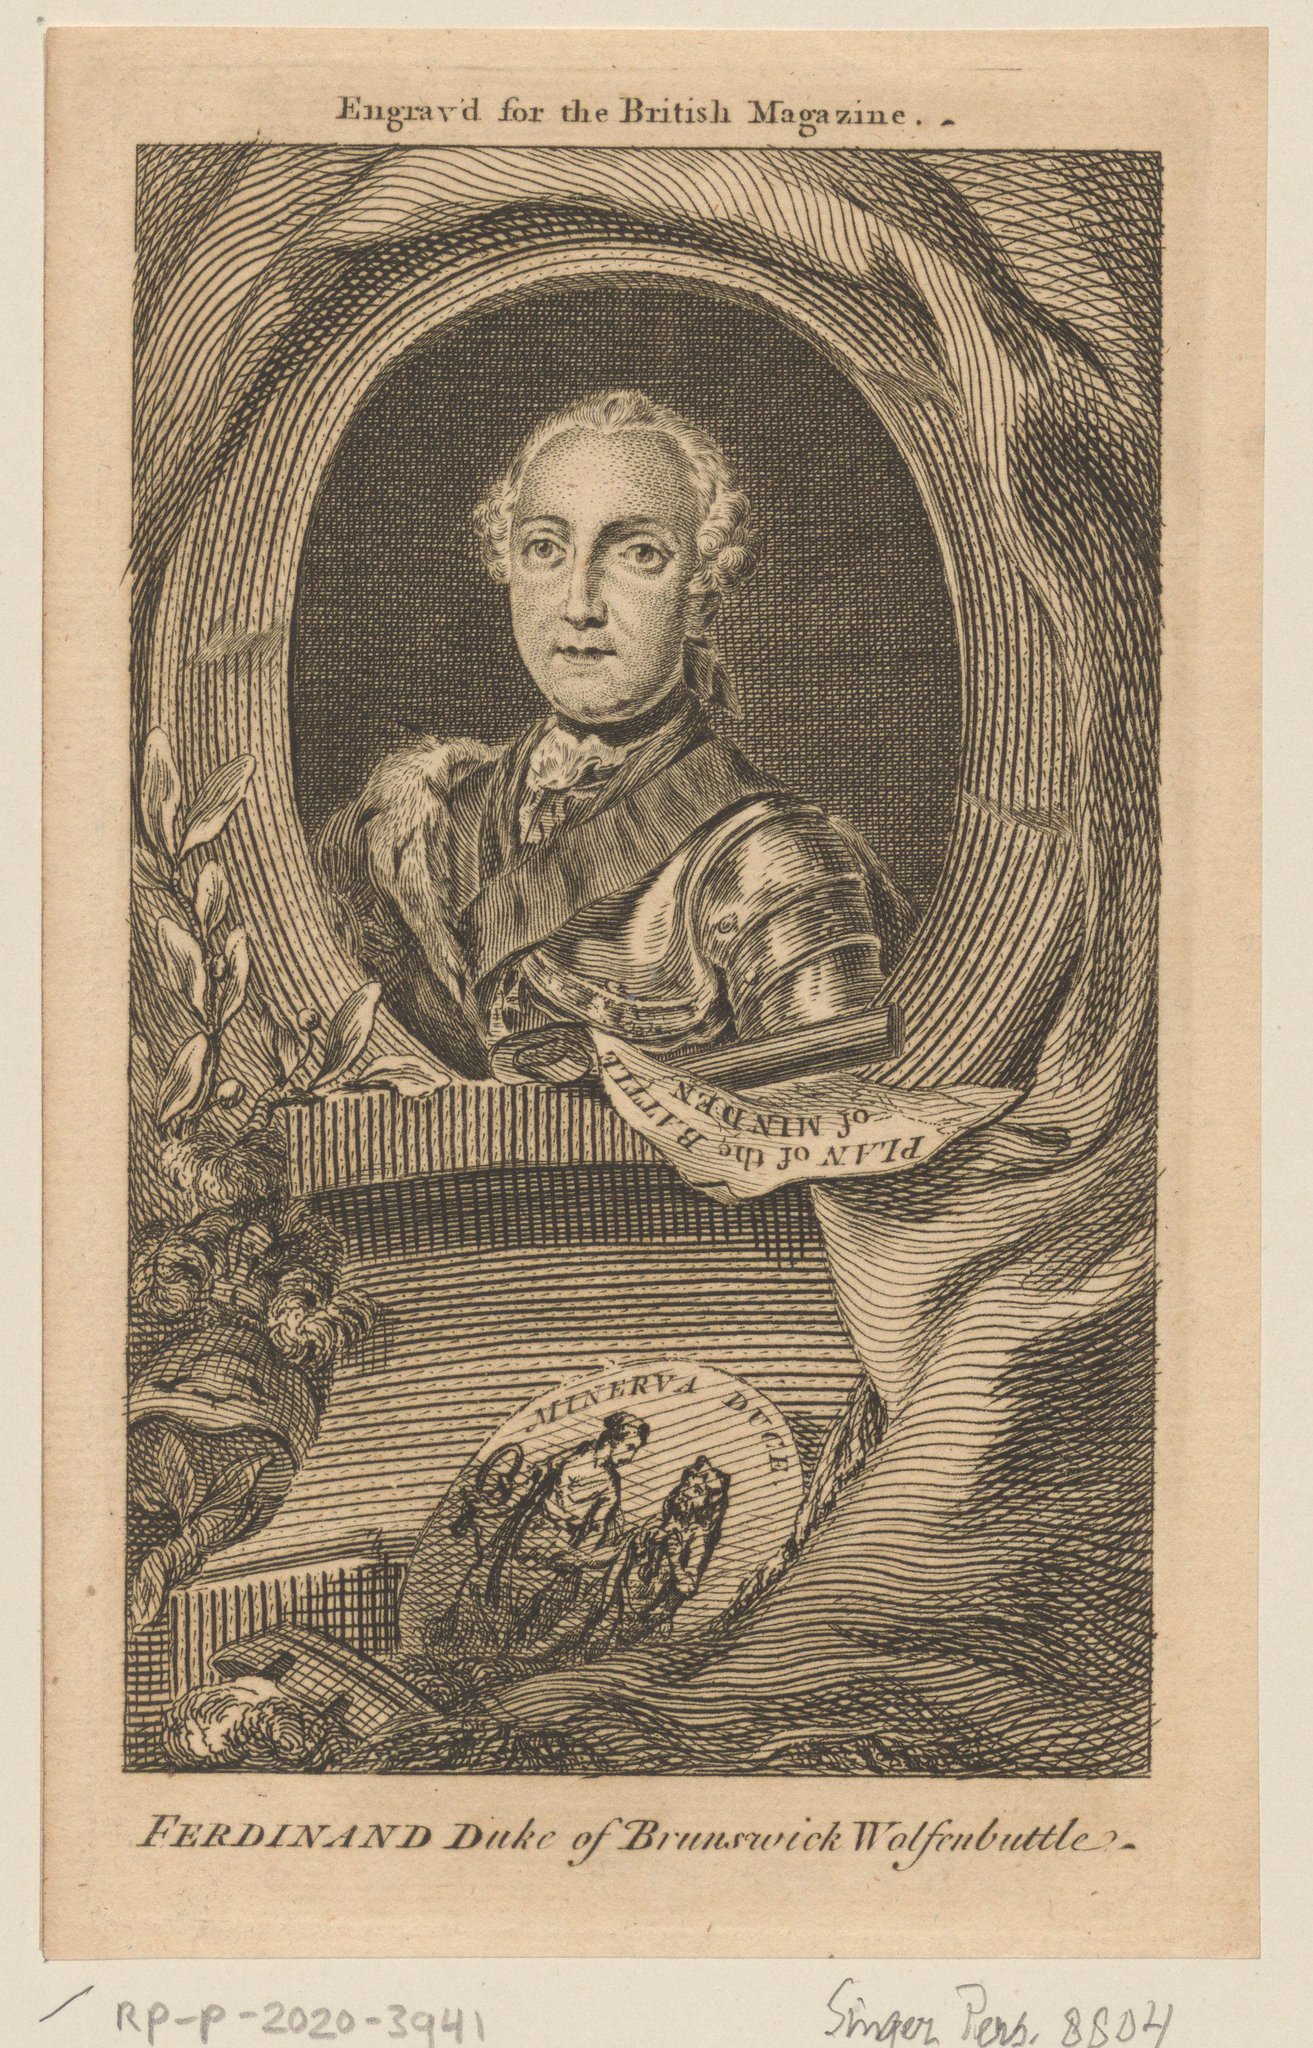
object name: print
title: Portret van Ferdinand van Brunswijk-Wolfenbüttel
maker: Anonymous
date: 1759-1760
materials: paper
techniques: engraving, etching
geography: england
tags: helmet, (story of) minerva (pallas, athena), historical persons, plan of battle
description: Onder het portret een stuk papier waarop staat: 'Plan of the Battle of Minden', 1 augustus 1759. Boven: 'Engrav'd for the British Magazine'.